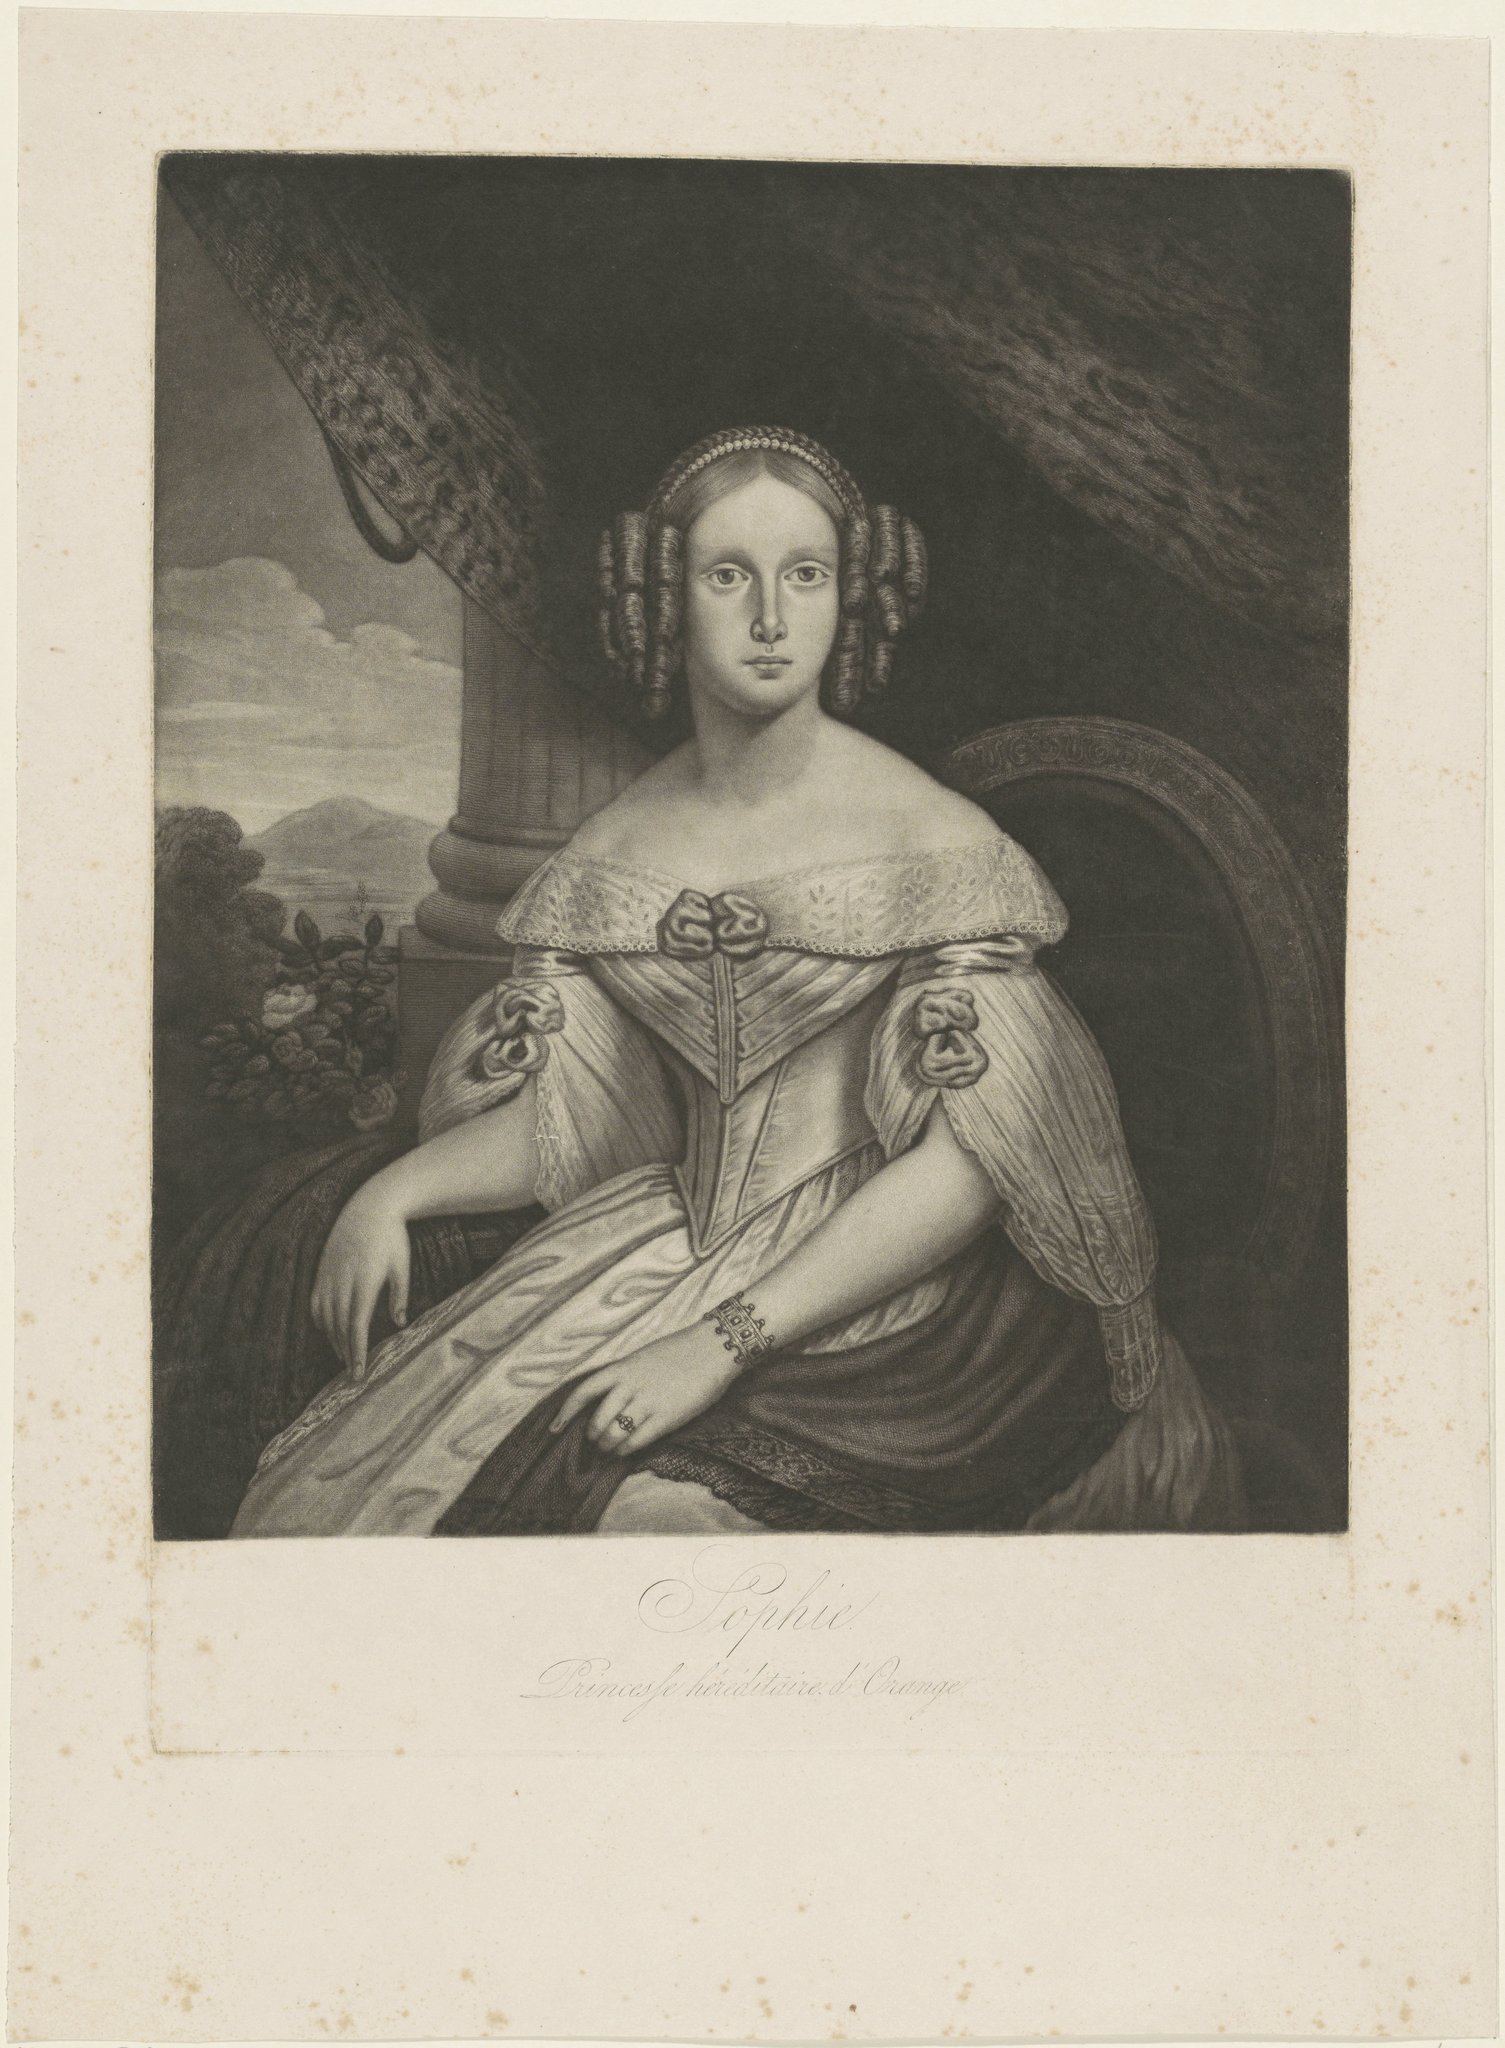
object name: print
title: Portret van Sophie van Württemberg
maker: Anonymous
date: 1839-1899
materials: paper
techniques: etching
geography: netherlands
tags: the hague, sophia frederika mathilda van württemberg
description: Portret van Sophie. Ze zit in een stoel. Links een doorkijkje naar een landschap. In de ondermarge haar naam en titel.